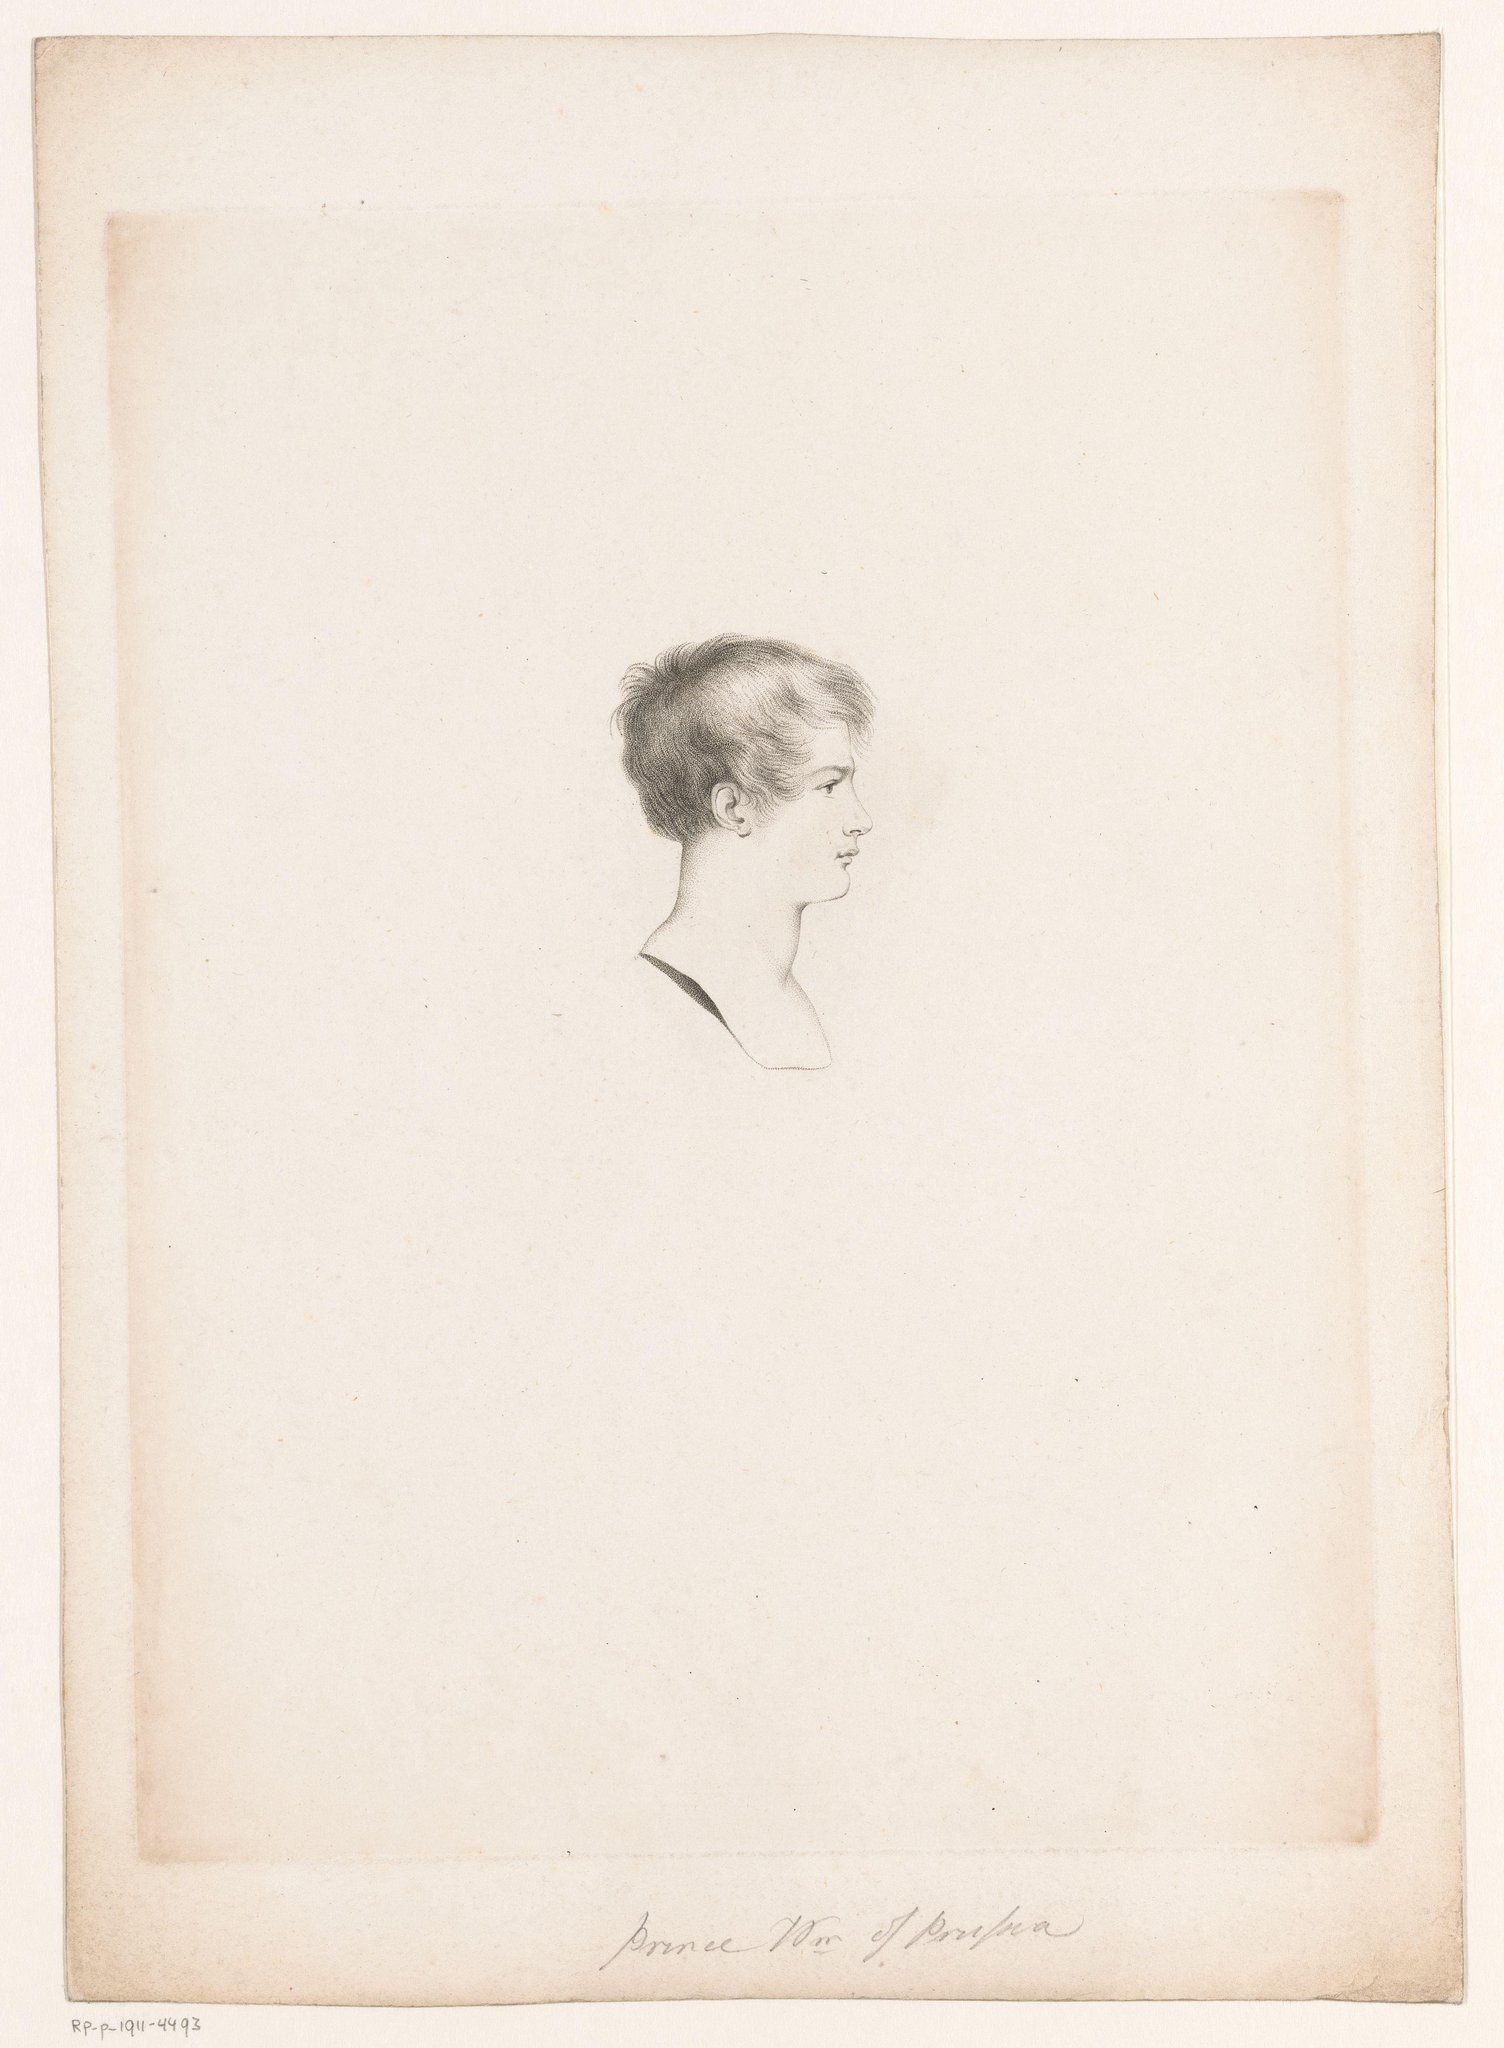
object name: print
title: Portret van Wilhelm I, keizer van Duitsland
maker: giovanni vendramini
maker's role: print maker, publisher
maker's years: 1769-1839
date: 1814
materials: paper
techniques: engraving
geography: london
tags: wilhelm i (keizer van duitsland), historical persons, emperor, ruler, sovereign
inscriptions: collector's mark: Lugt 2228